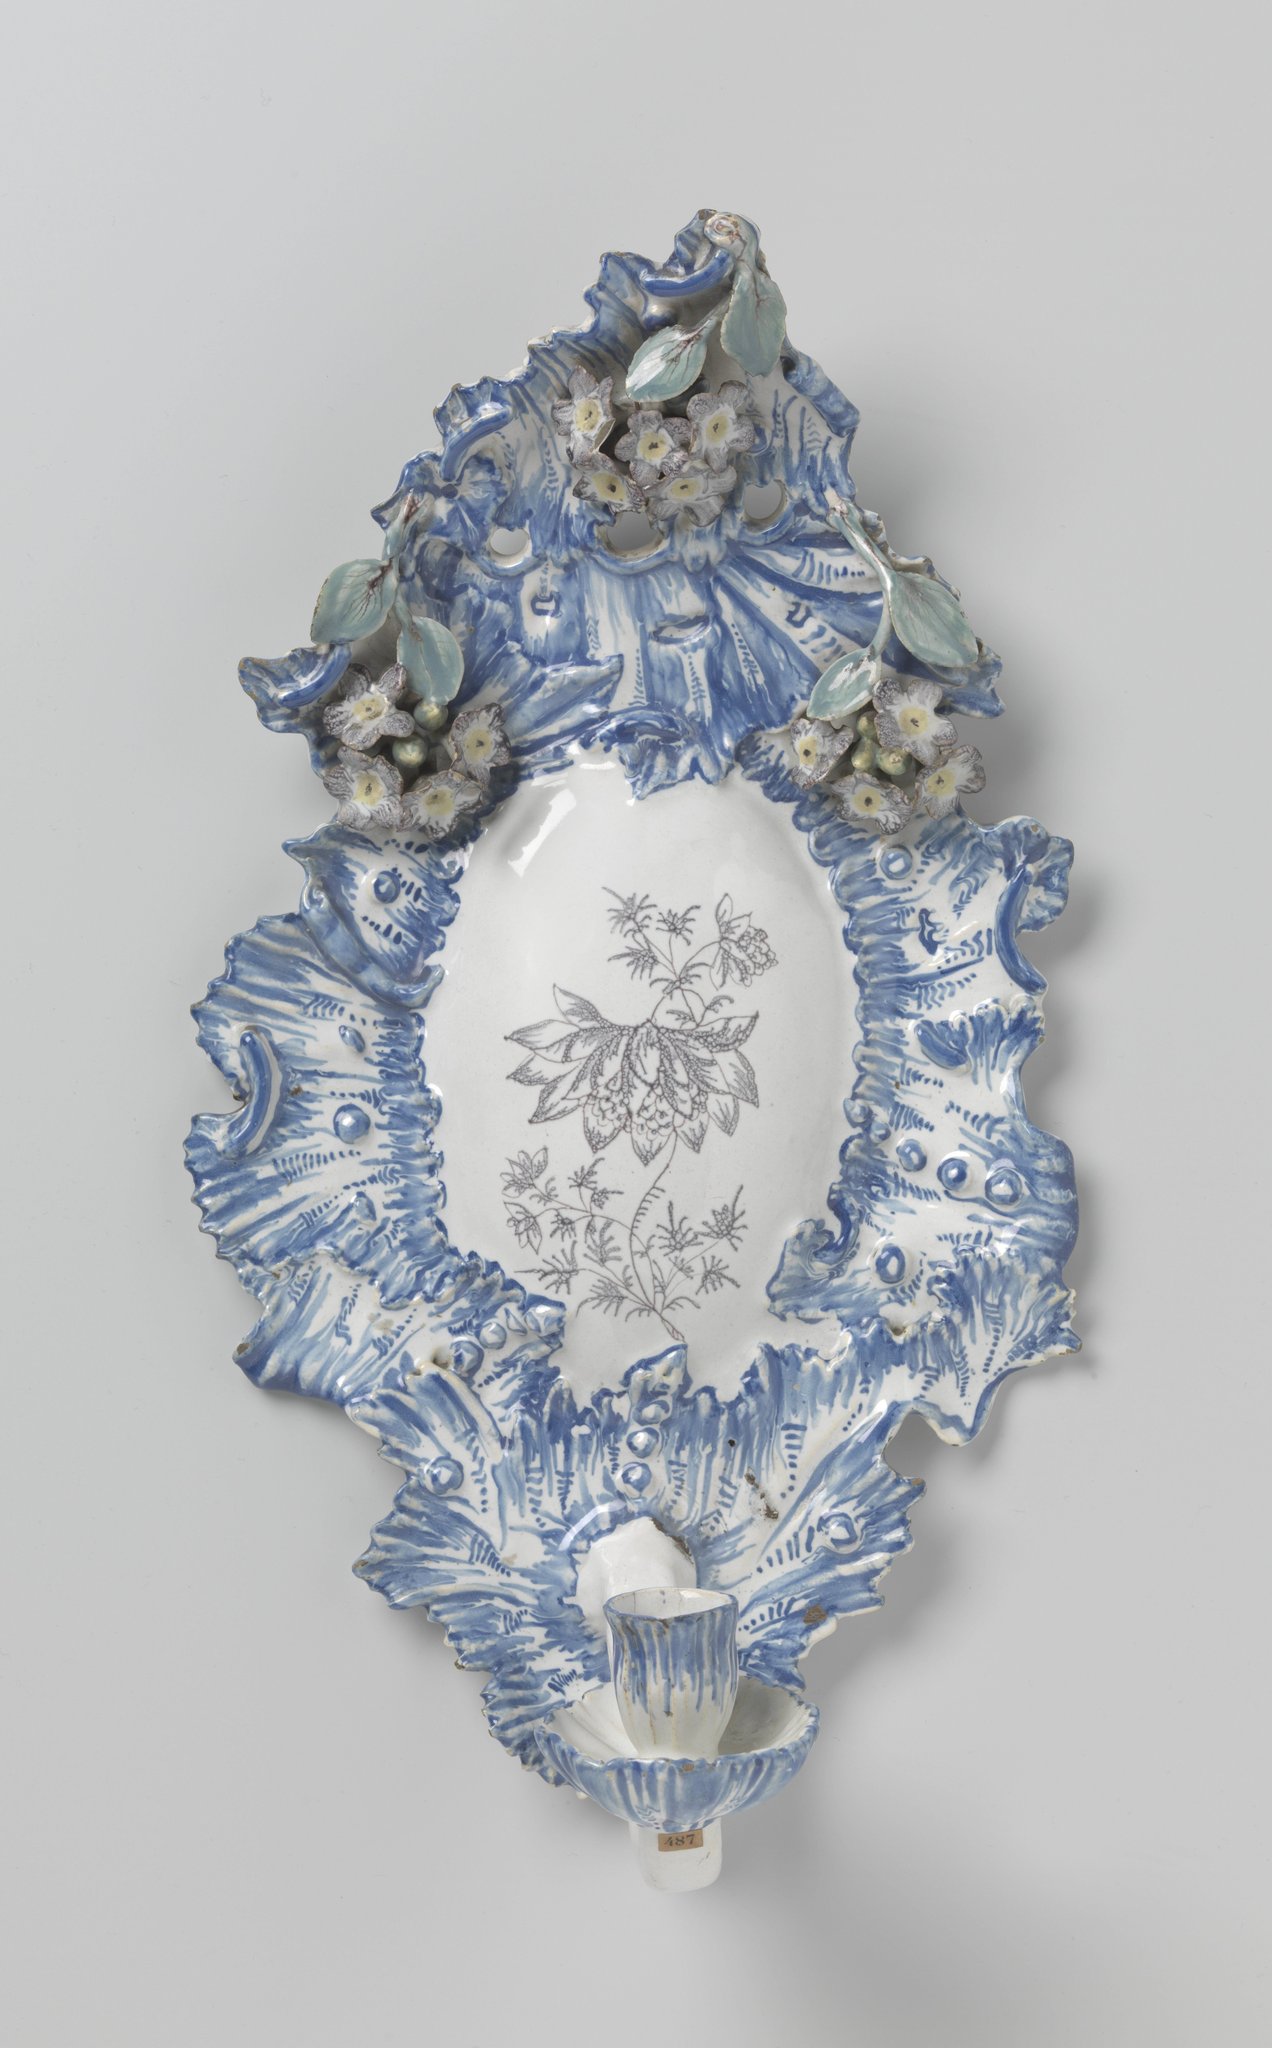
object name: sconce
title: Ovale applique met wandarm van veelkleurig beschilderde faïence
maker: Anonymous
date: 1755-1770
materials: earthenware, glaze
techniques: painted, polychromy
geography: germany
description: Ovale wandarm van veelkleurig beschilderde faïence. Op het midden is een bloemenrank geschilderd met daar omheen een geschulpte rand met bloemen in relief. Onderaan de wandarm is een kaarsenhouder bevestigd. Bij de wandarm hoort een identiek exemplaar.